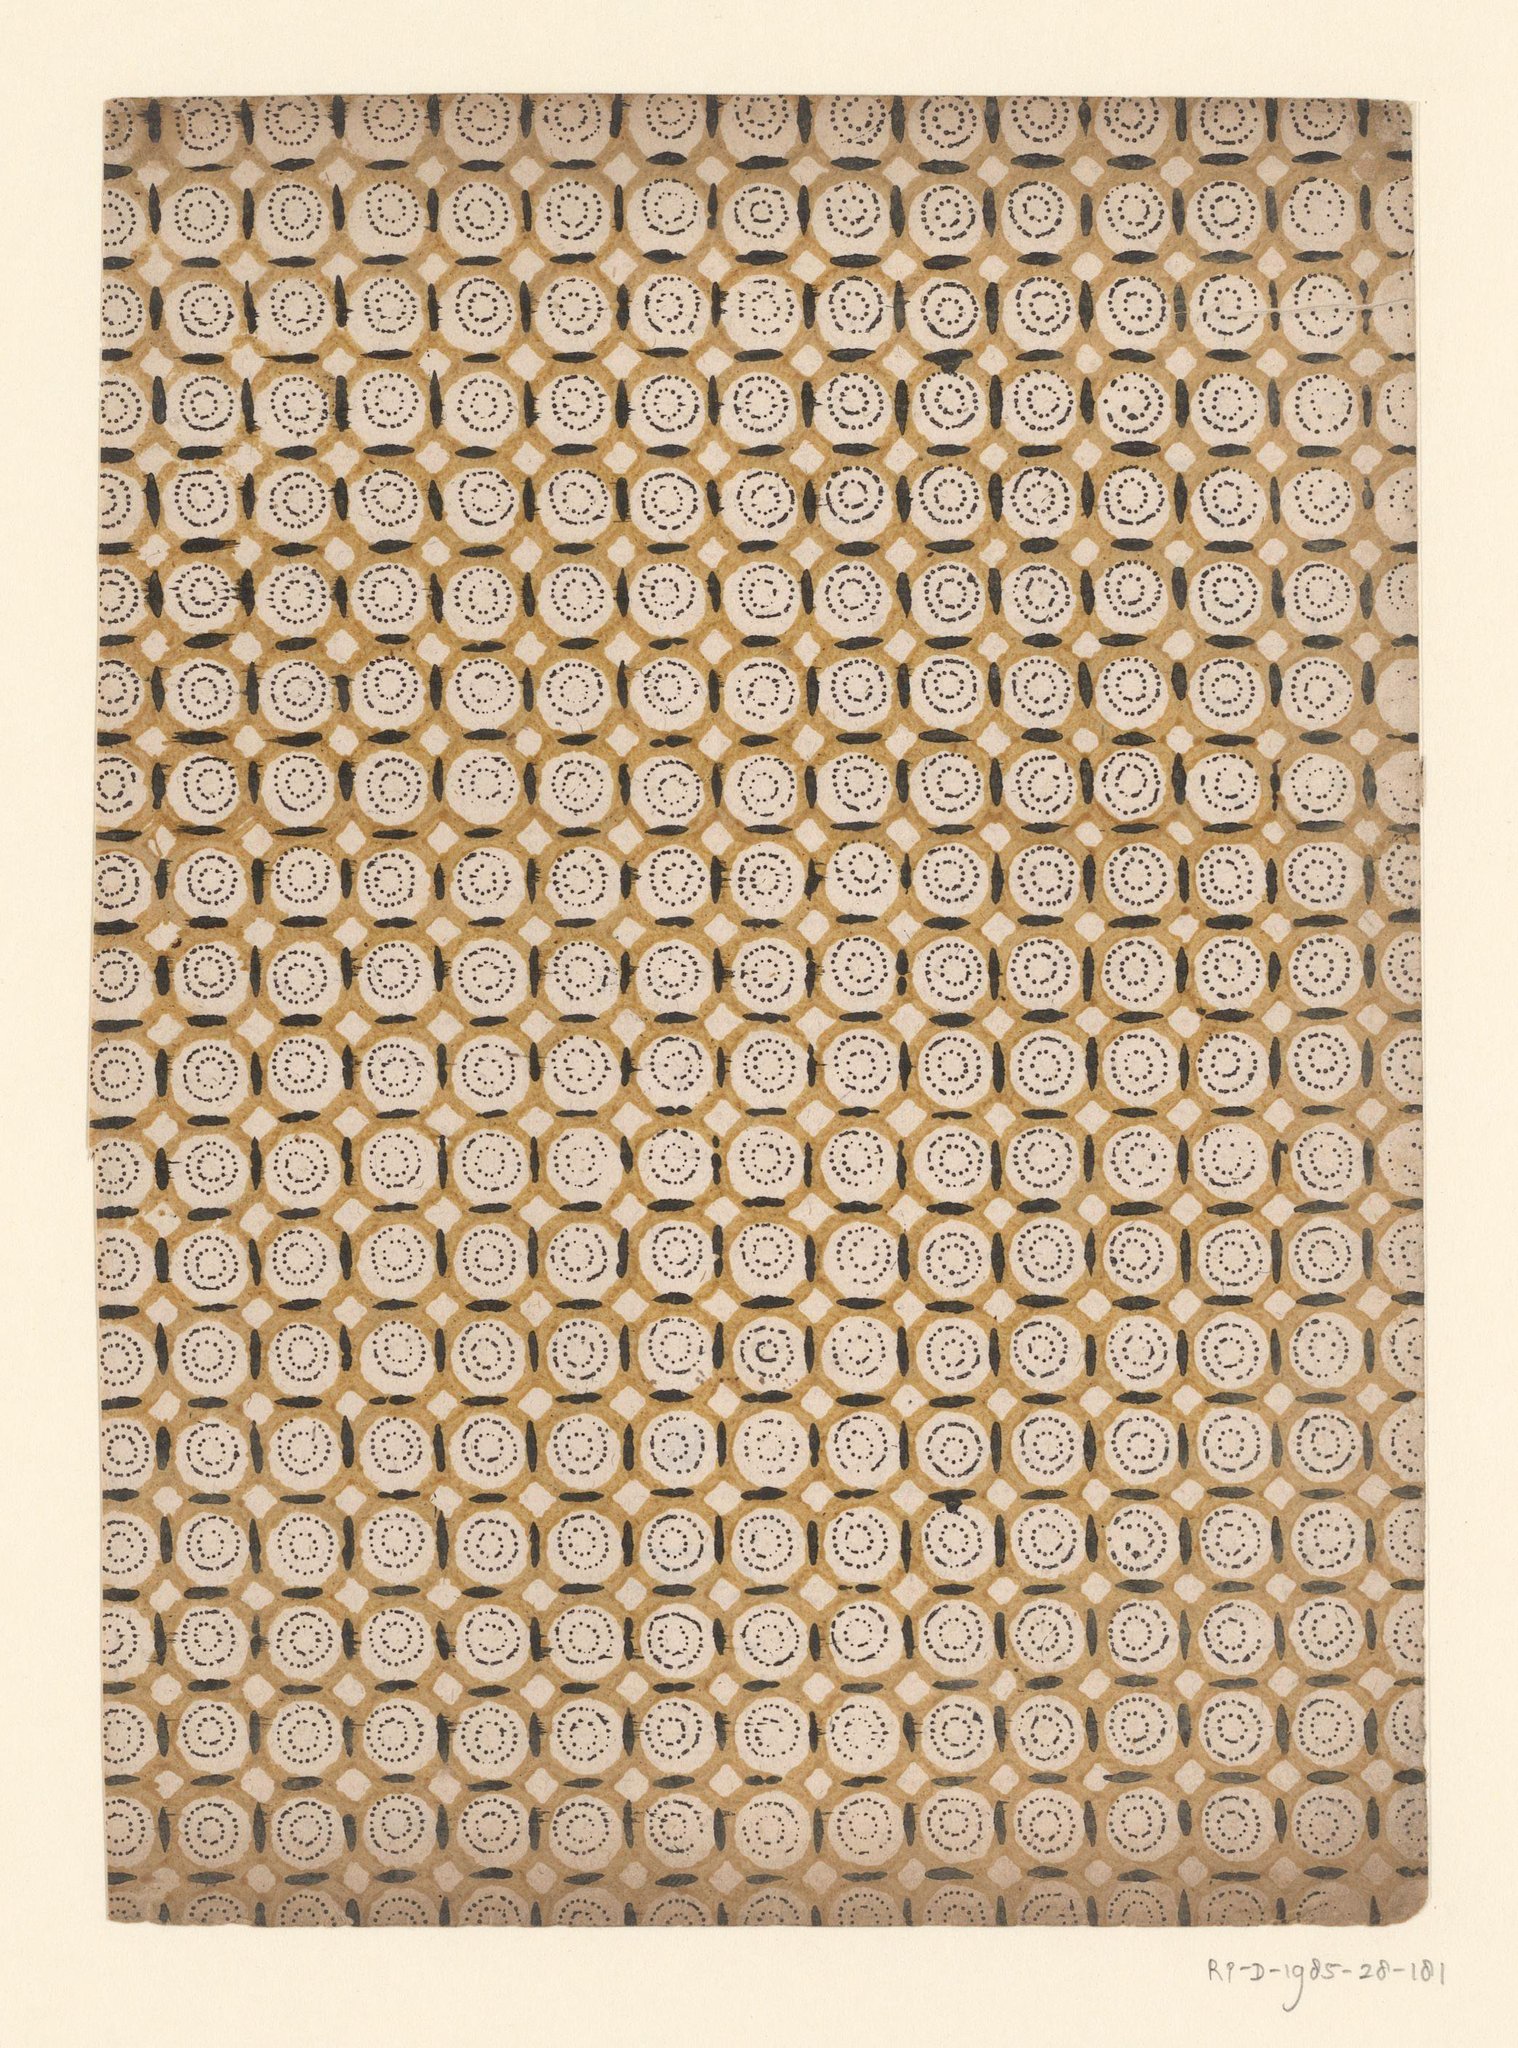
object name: printed paper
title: Blad met strooipatroon van uitgespaarde cirkels gevuld met punten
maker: Anonymous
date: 1750-1900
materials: paper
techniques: printing block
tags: ornament ~ geometric motifs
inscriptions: collector's mark: Lugt 2228, collector's mark: Lugt 2760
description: Blad met strooipatroon van uitgespaarde cirkels gevuld met punten. Helft van een omslag.